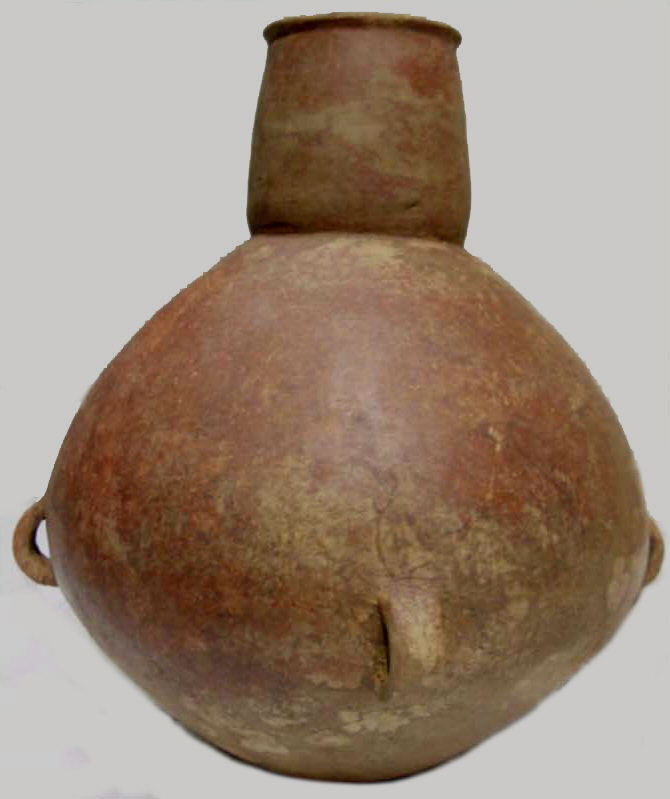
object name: jar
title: Jar with Four Lugs (Guan)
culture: chinese, northeast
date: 3000 BCE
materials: earthenware